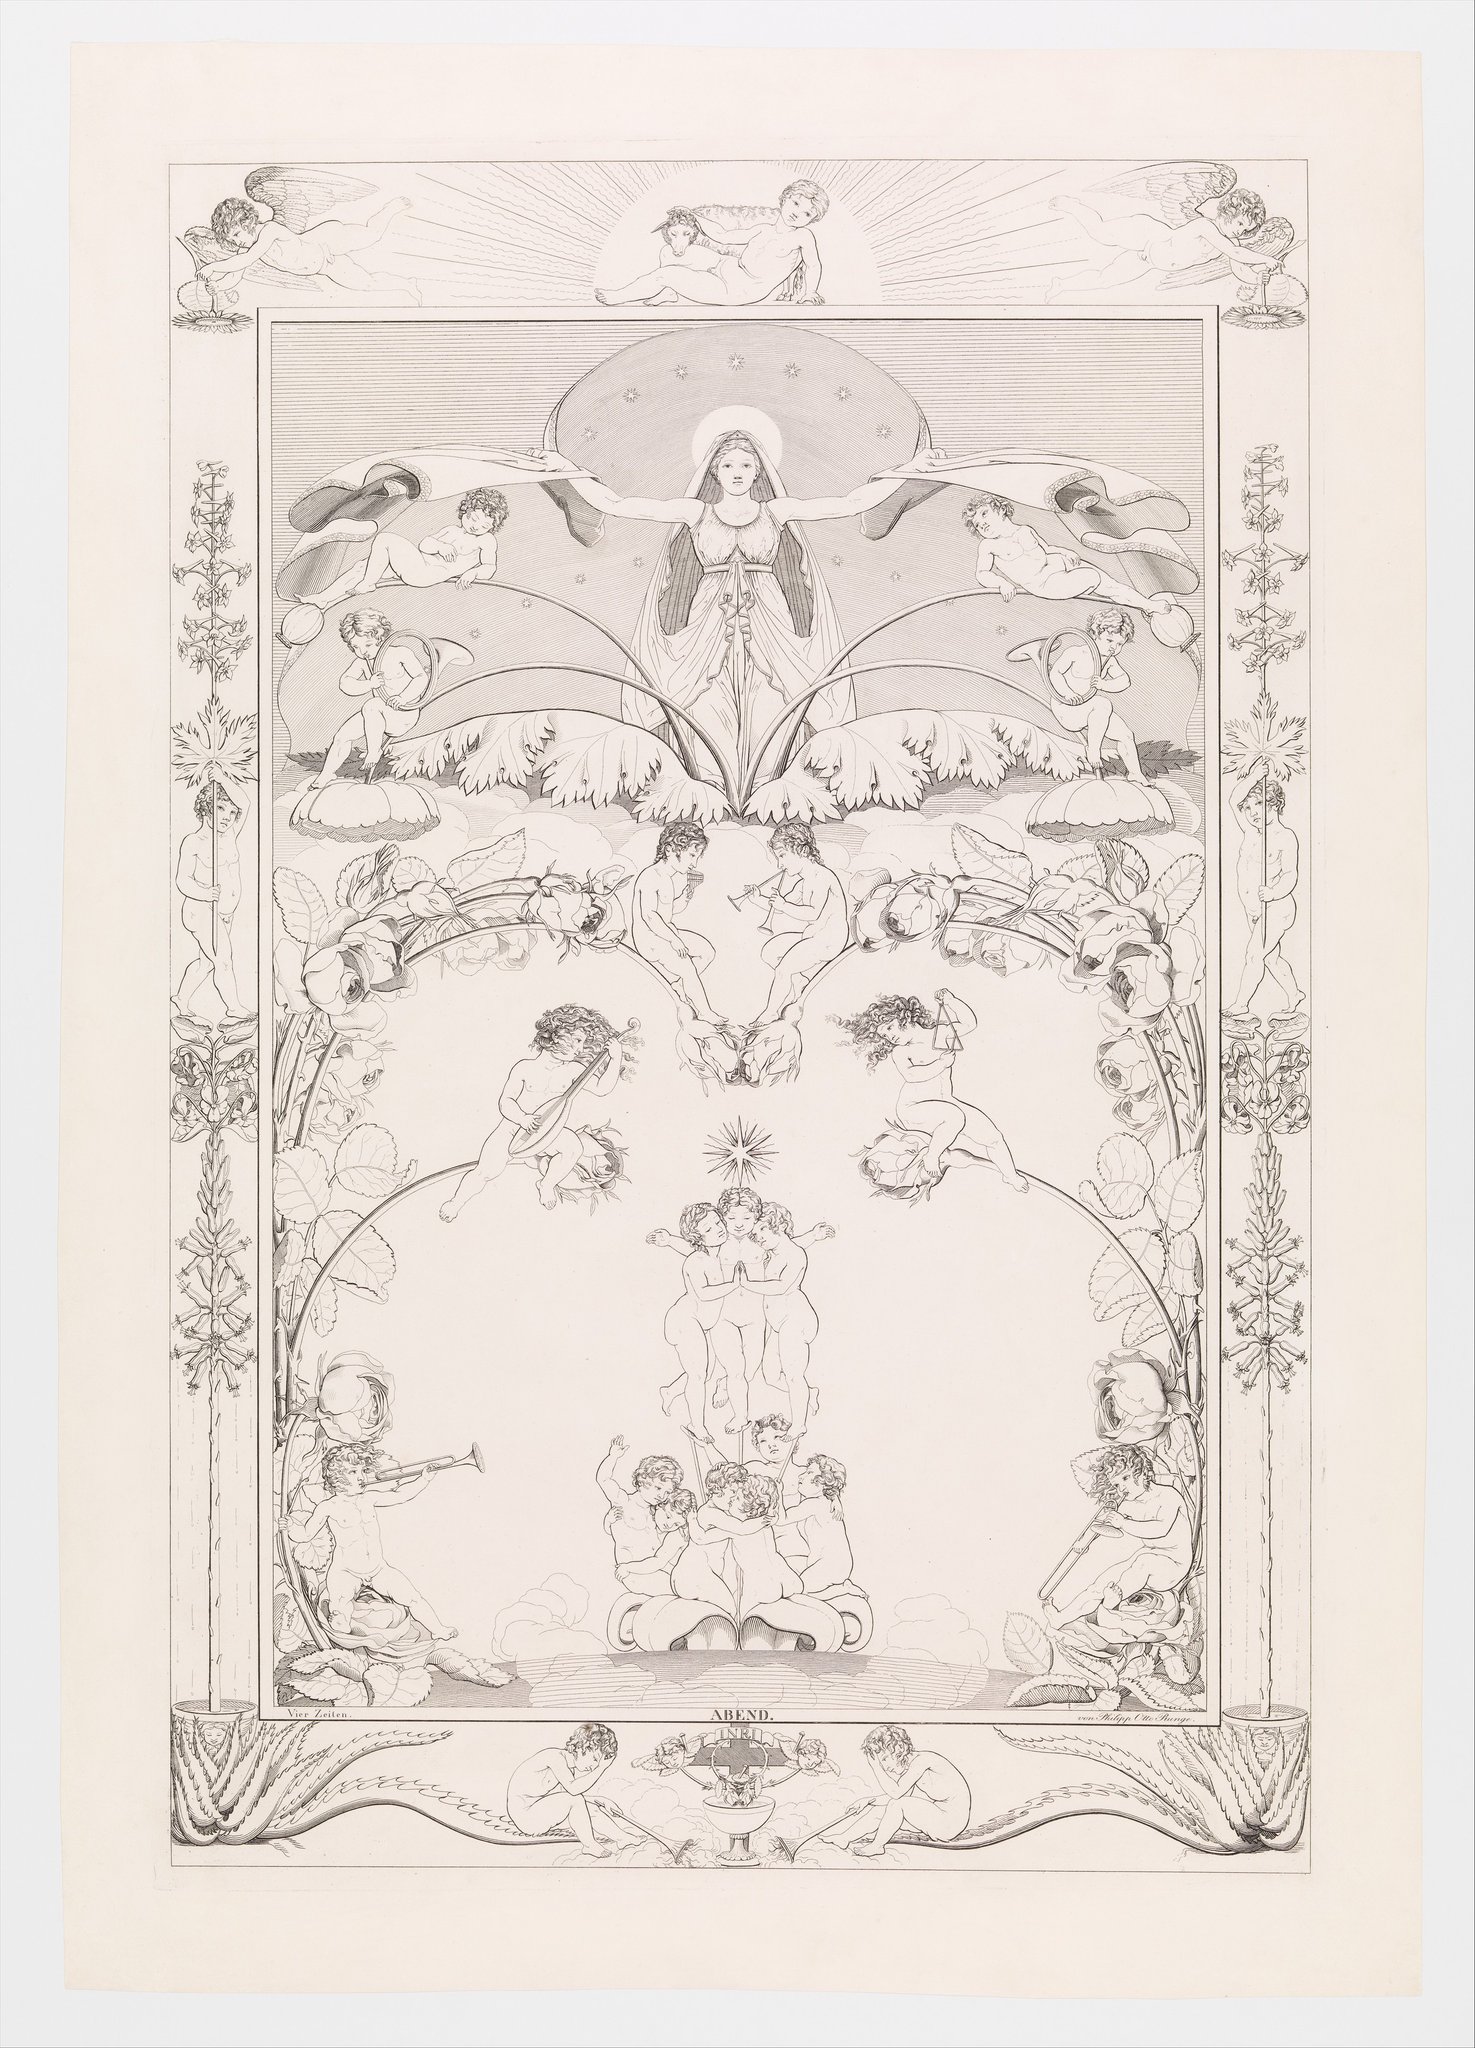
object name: print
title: Evening, from the series The Times of the Day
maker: philipp otto runge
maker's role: artist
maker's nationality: german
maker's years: 1777-1810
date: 1807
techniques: engraving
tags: musical instruments,goddess